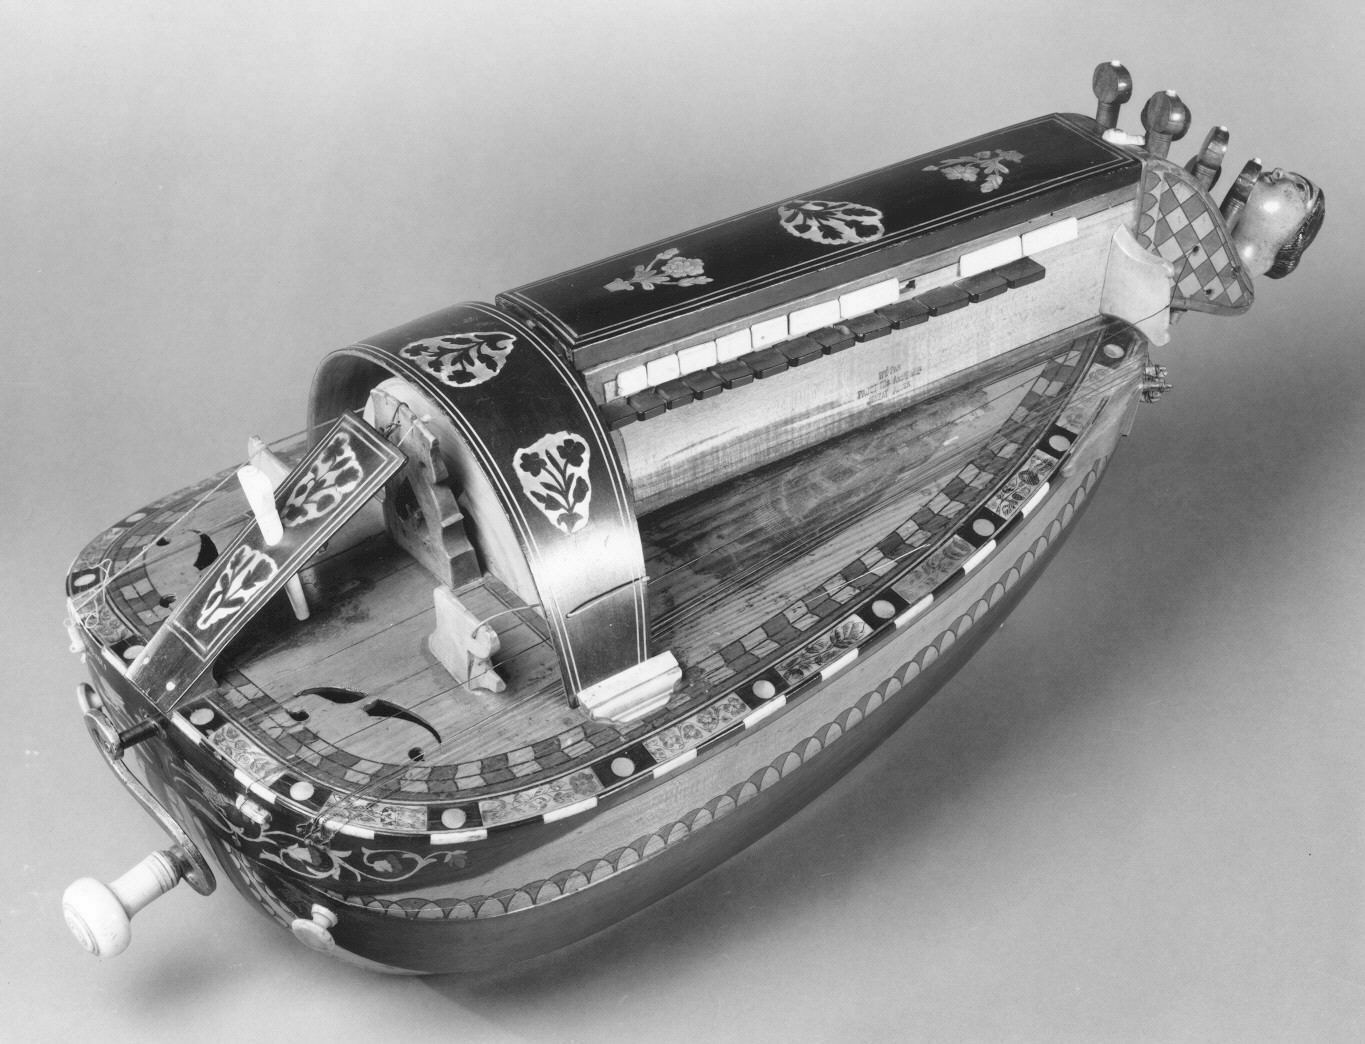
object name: hurdy gurdy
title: Hurdy-Gurdy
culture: french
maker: gilbert nigout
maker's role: maker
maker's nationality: french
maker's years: 1863-1919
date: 1879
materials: bone, ivory, mother of pearl, wood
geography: france